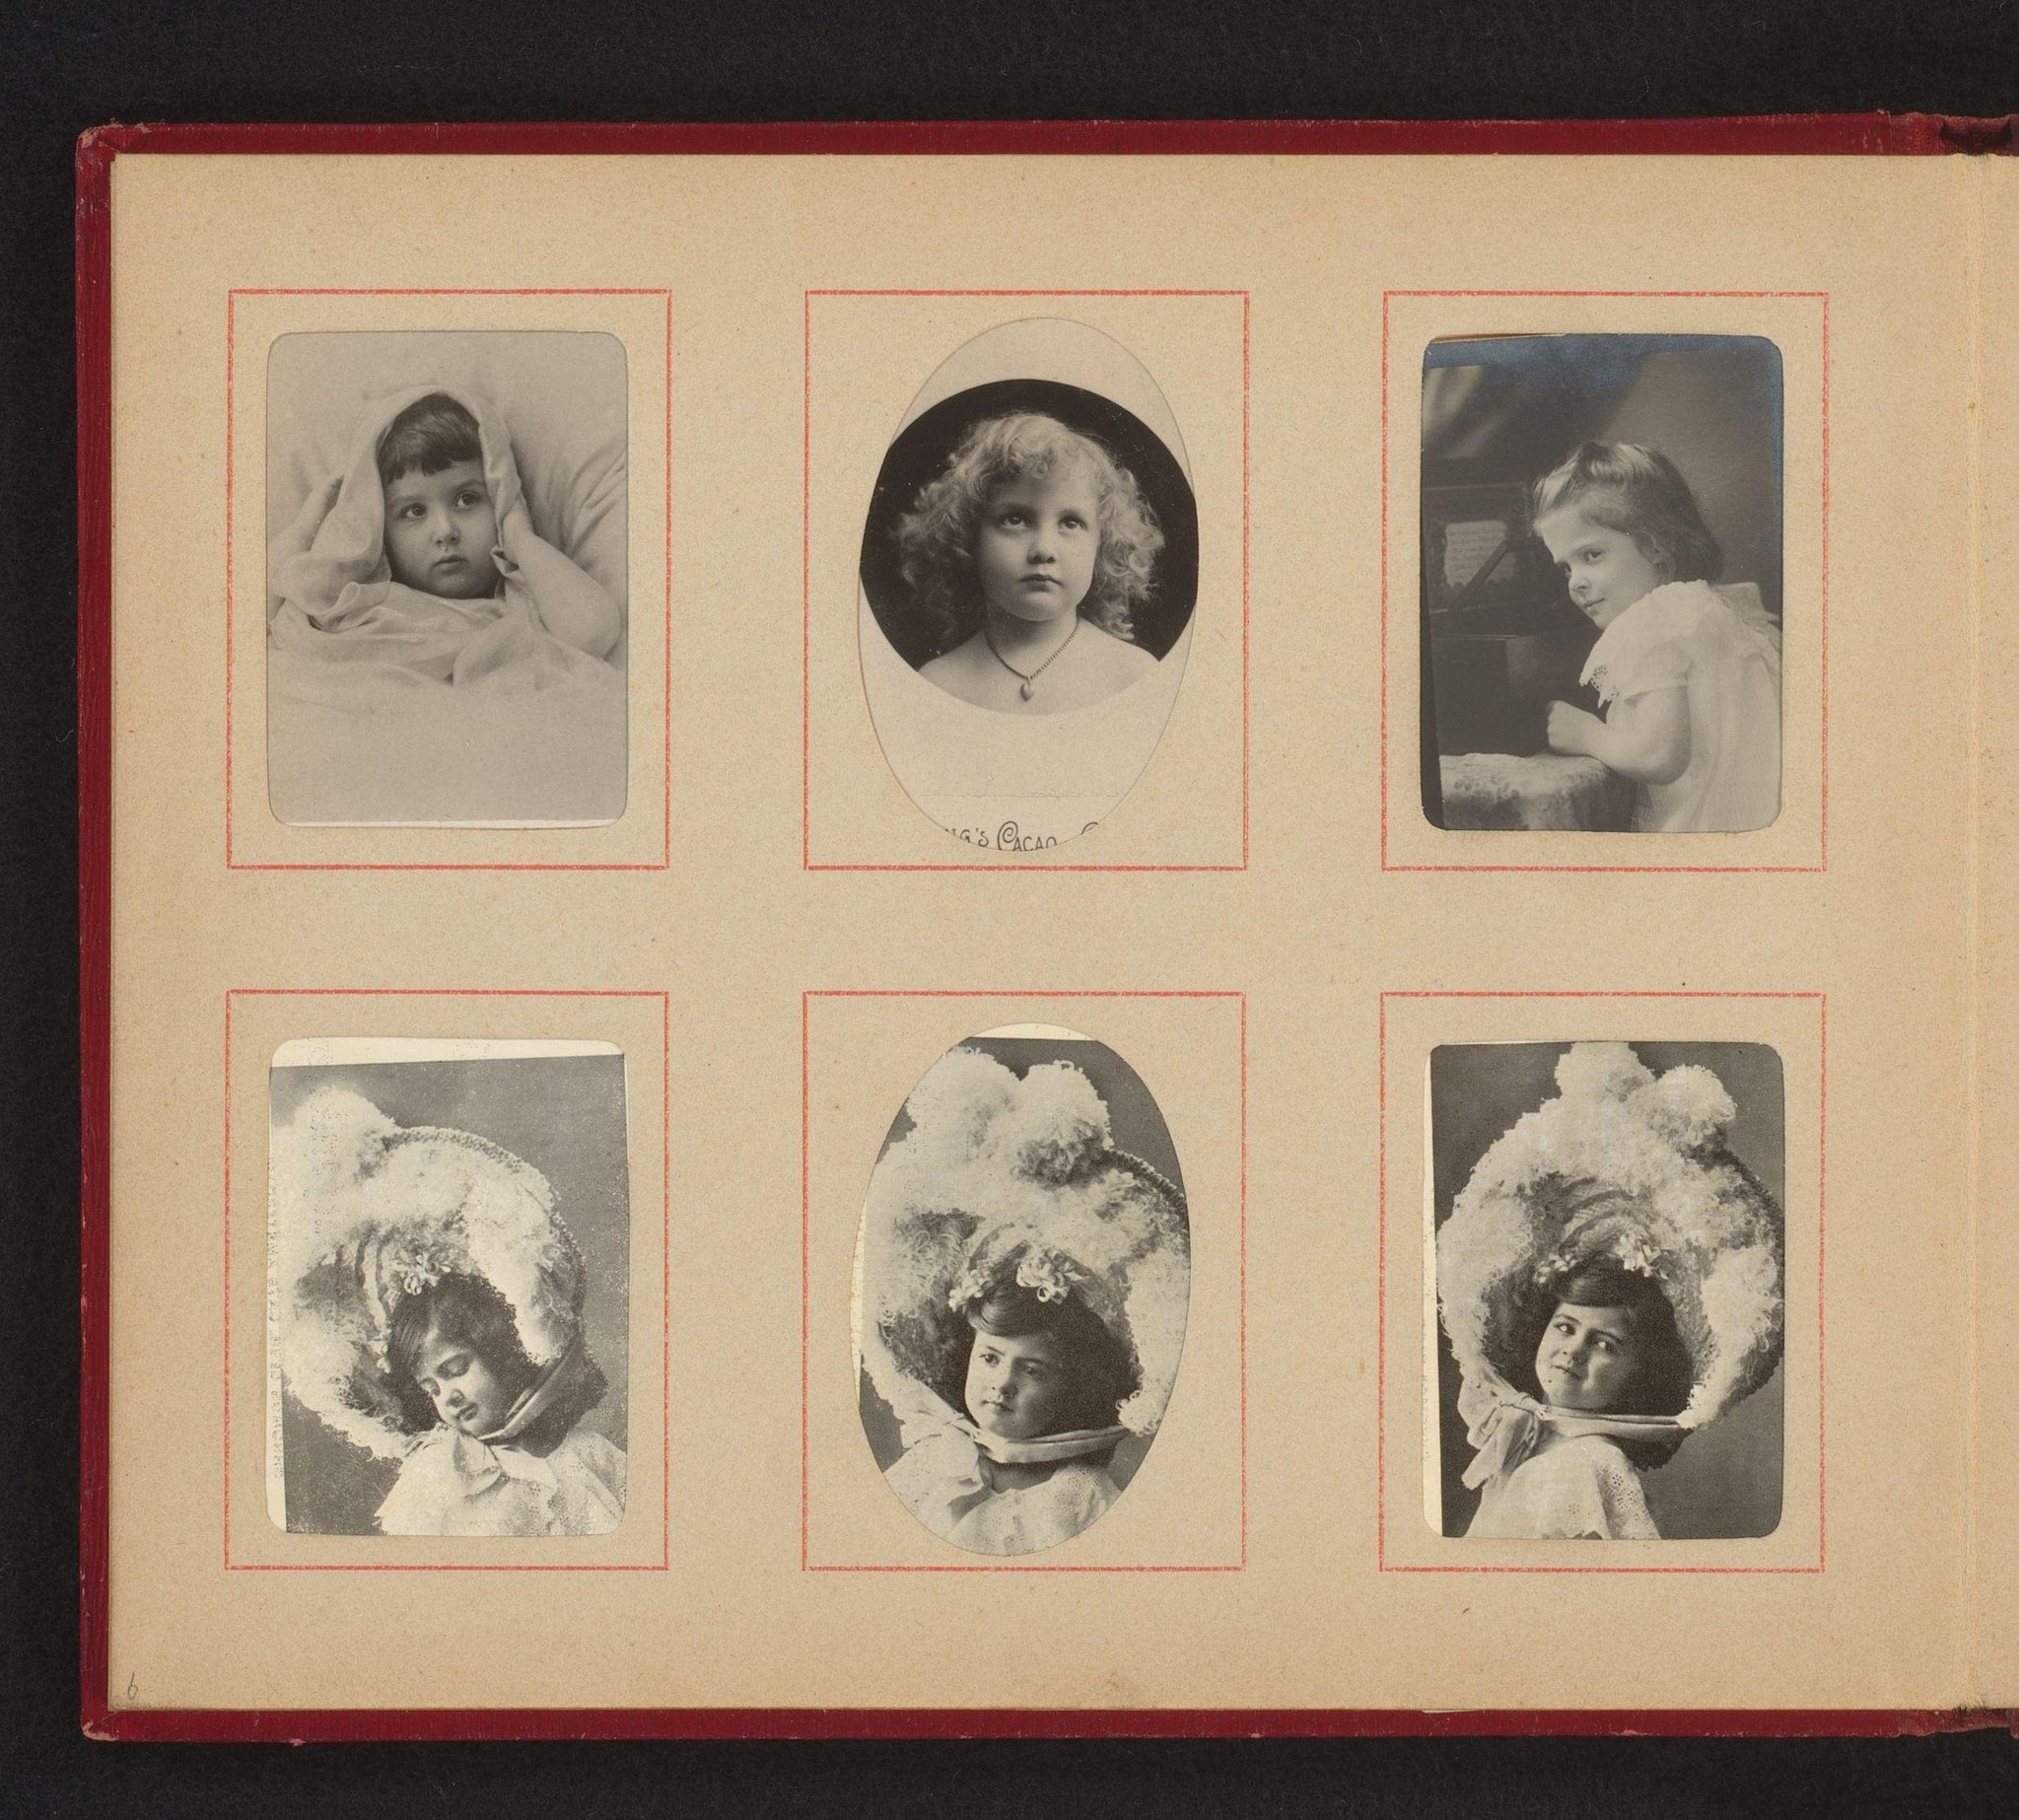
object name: album leaf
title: Kinderportretten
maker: Anonymous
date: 1880-1920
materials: photographic support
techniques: gelatin silver print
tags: child, historical persons, trade games, imitative games, imitating adults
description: Zes portretten van kinderen, waaronder drie van een meisje met een hoofddeksel. Deze pagina maakt deel uit van een album.